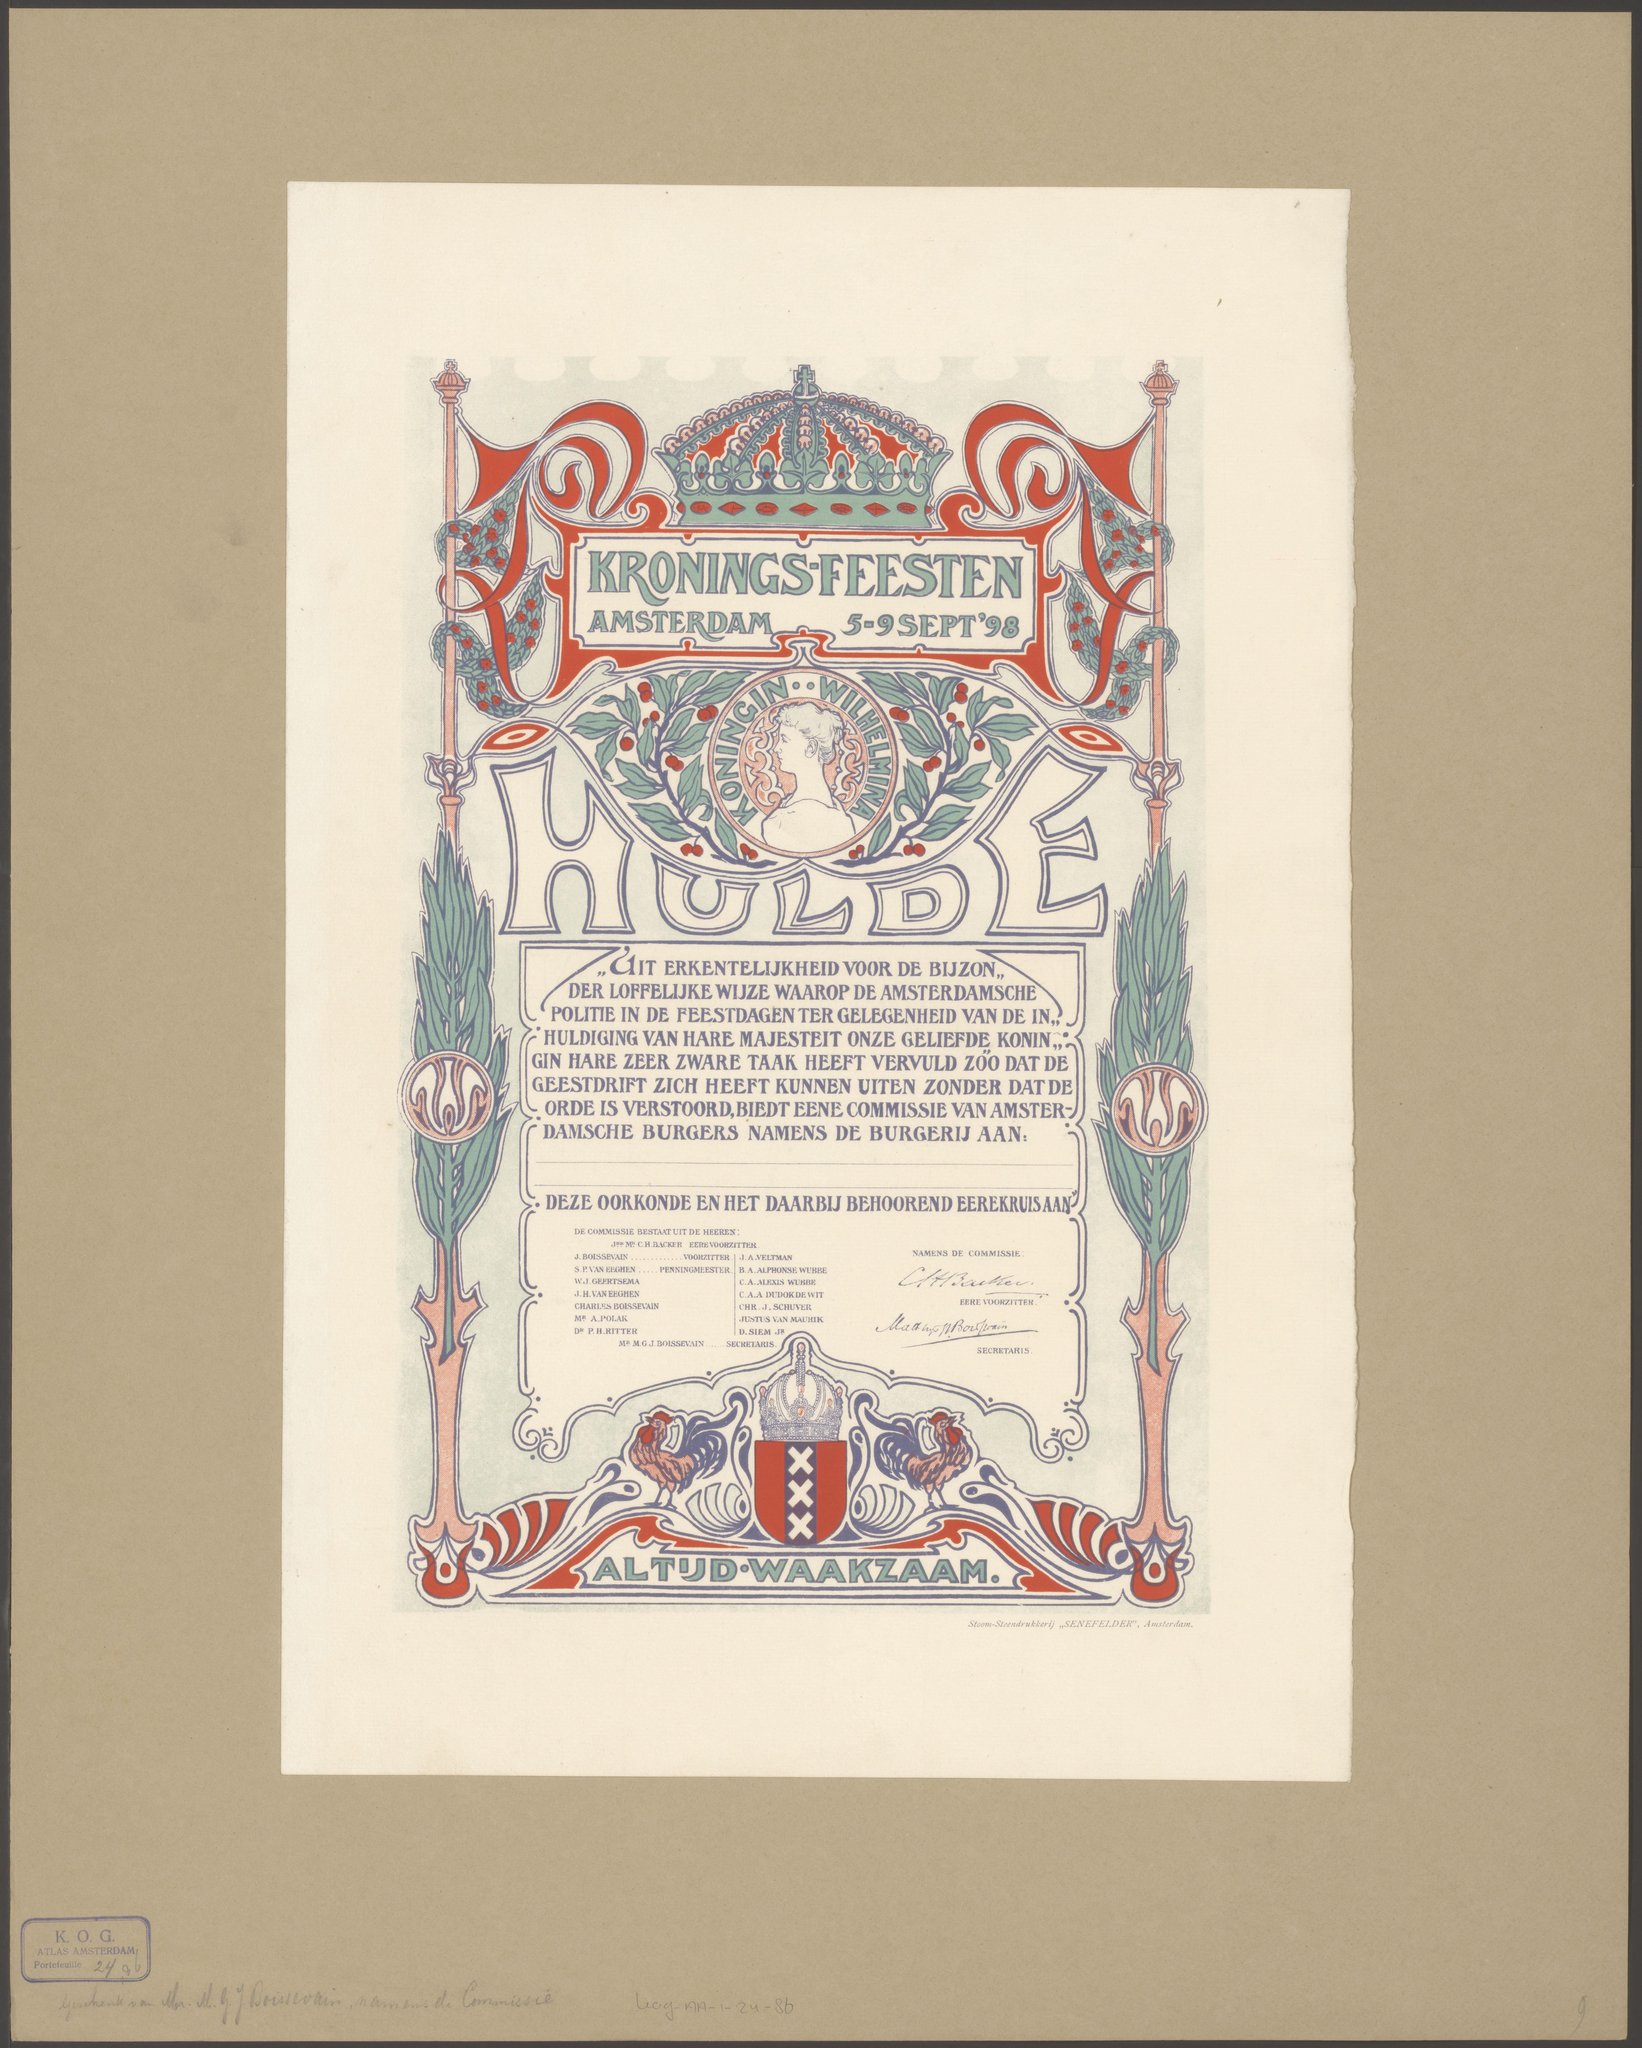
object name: print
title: Hulde aan de politie voor haar werk tijdens de Kroningsfeesten van koningin Wilhelmina te Amsterdam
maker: Anonymous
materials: paper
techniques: chromolithography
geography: netherlands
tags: the hague, print maker, wilhelmina of the netherlands, coat of arms (as symbol of the state, etc.) (+ city; municipal), crown (symbol of sovereignty), public festivities on the occasion of royal events, fowl (cock, hen, chicken, etc.), police, amsterdam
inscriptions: collector's mark: Lugt 1641b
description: Onderwerpsrubriek binnen de Atlas Amsterdam: Politie.